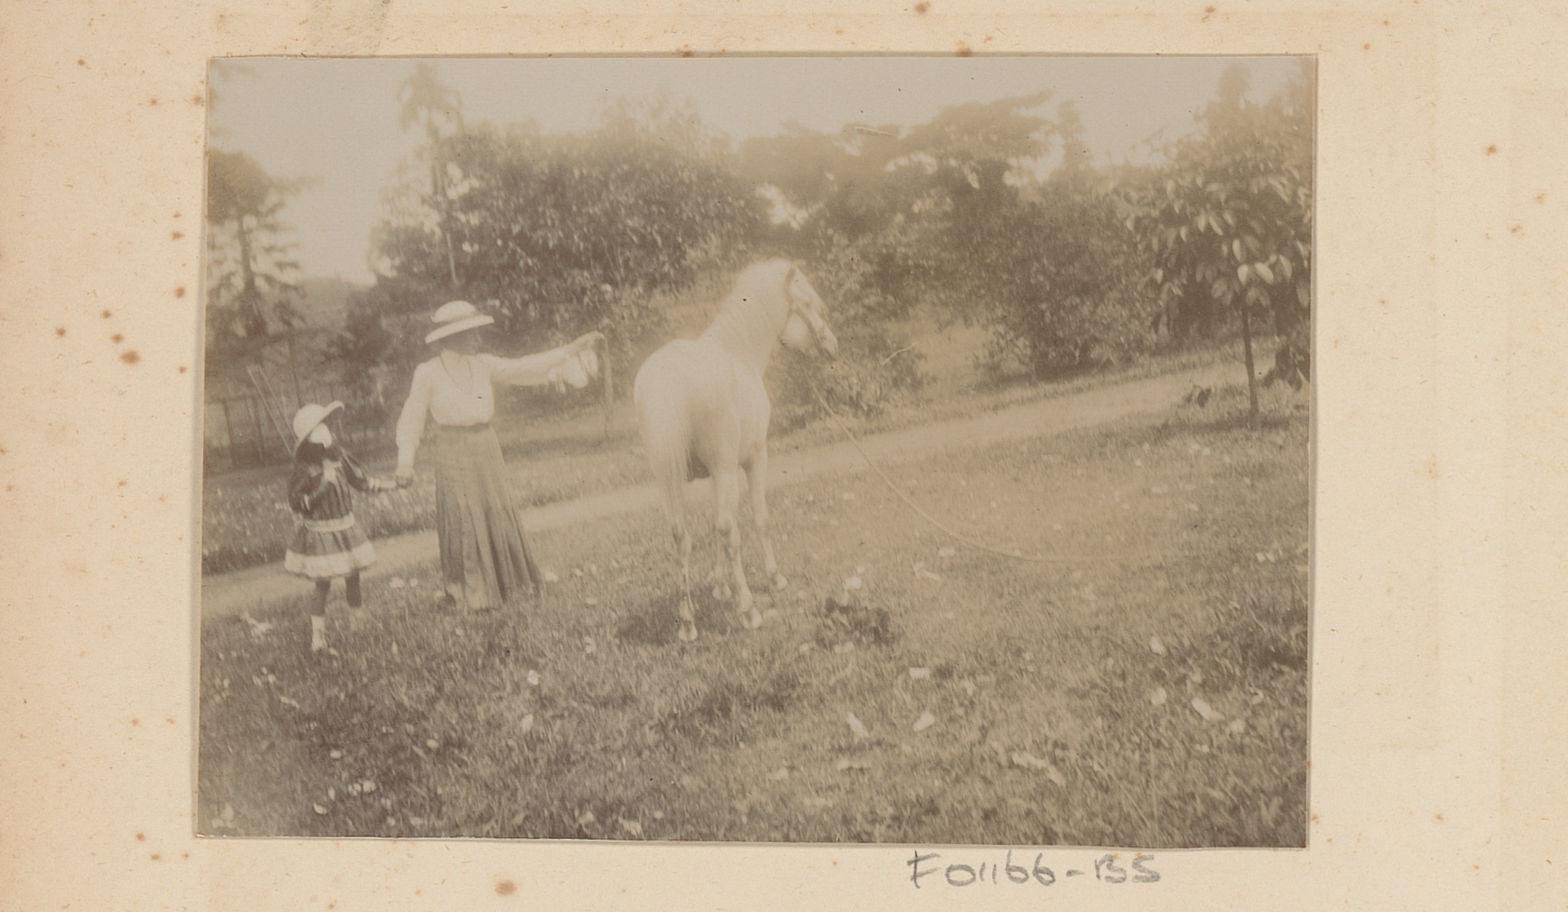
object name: photograph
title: Moeder en dochter bij een paard in de wei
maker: Anonymous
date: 1895-1910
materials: photographic support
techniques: gelatin silver print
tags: historical persons, mother and daughter(s) (family group), horse, dutch east indies, the